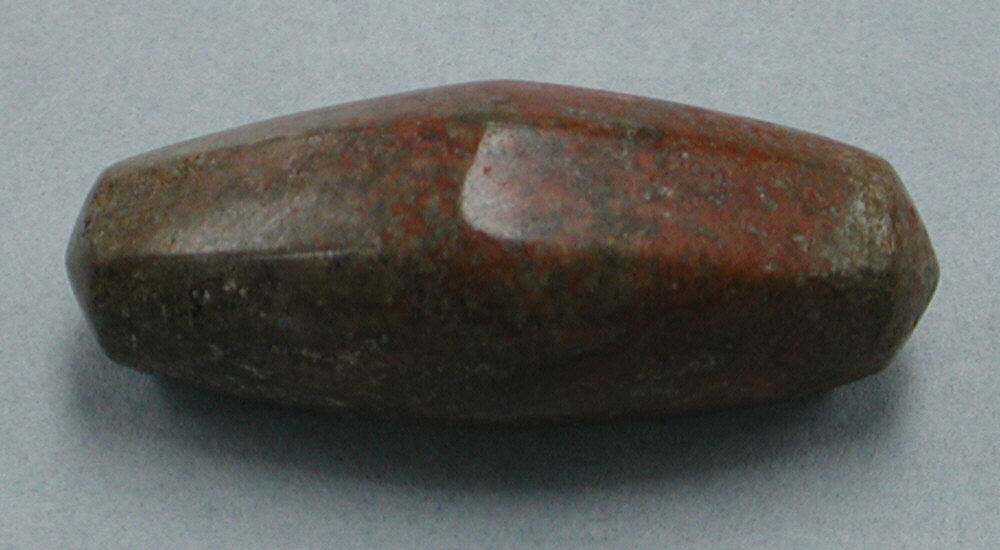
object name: ritual stone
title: Stone Pulidor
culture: mexican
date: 1501-1600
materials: stone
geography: mexico